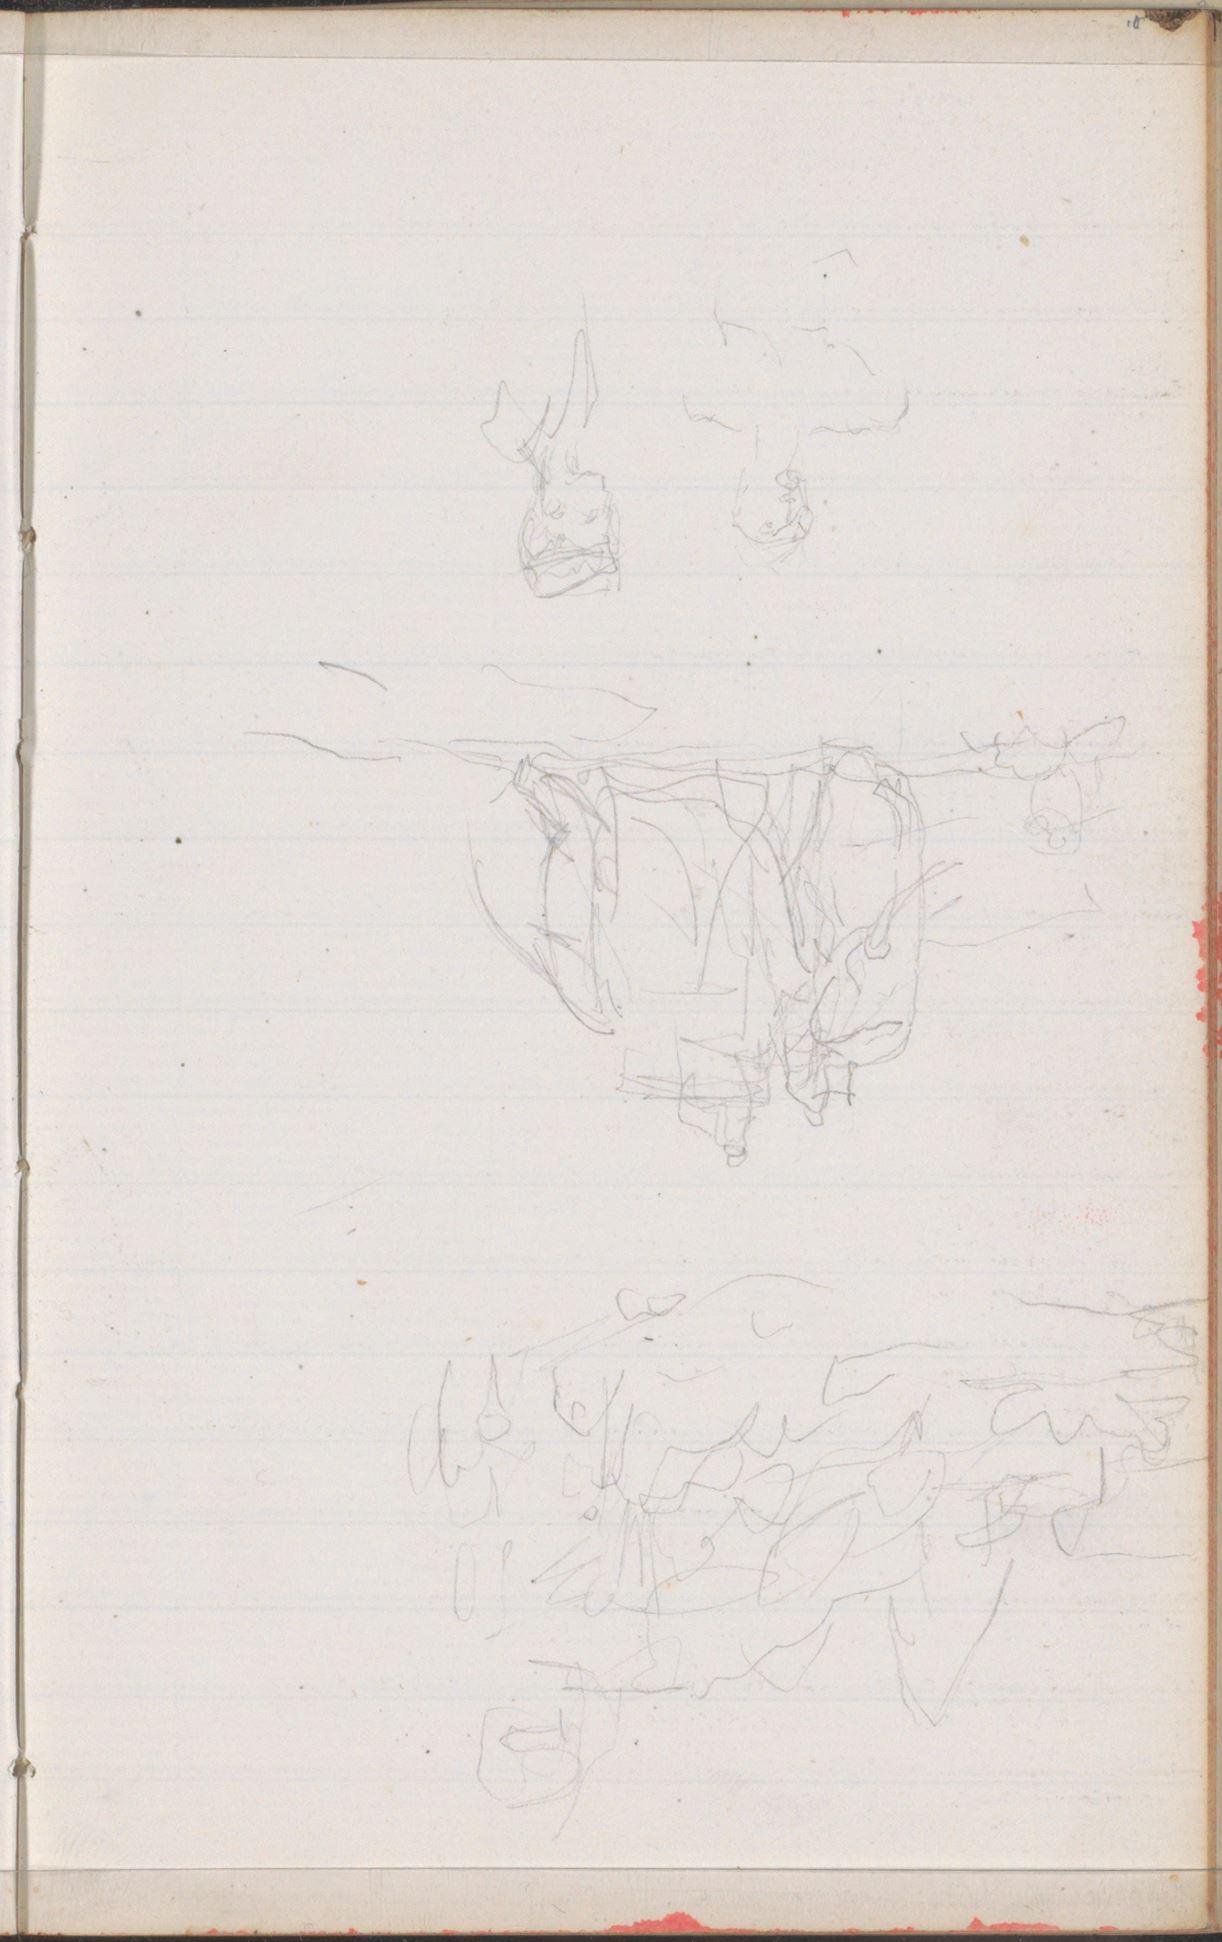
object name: sketchbook leaf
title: Studieblad, onder andere met figuren op een olifant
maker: marius bauer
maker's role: draughtsman, print maker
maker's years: 1867-1932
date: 1897-1898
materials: pencil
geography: india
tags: asiatic races and peoples: indians, trunked animals: elephant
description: Tevens figuurstudies van Indiërs. Pagina 18 uit een schetsboek met 62 bladen.